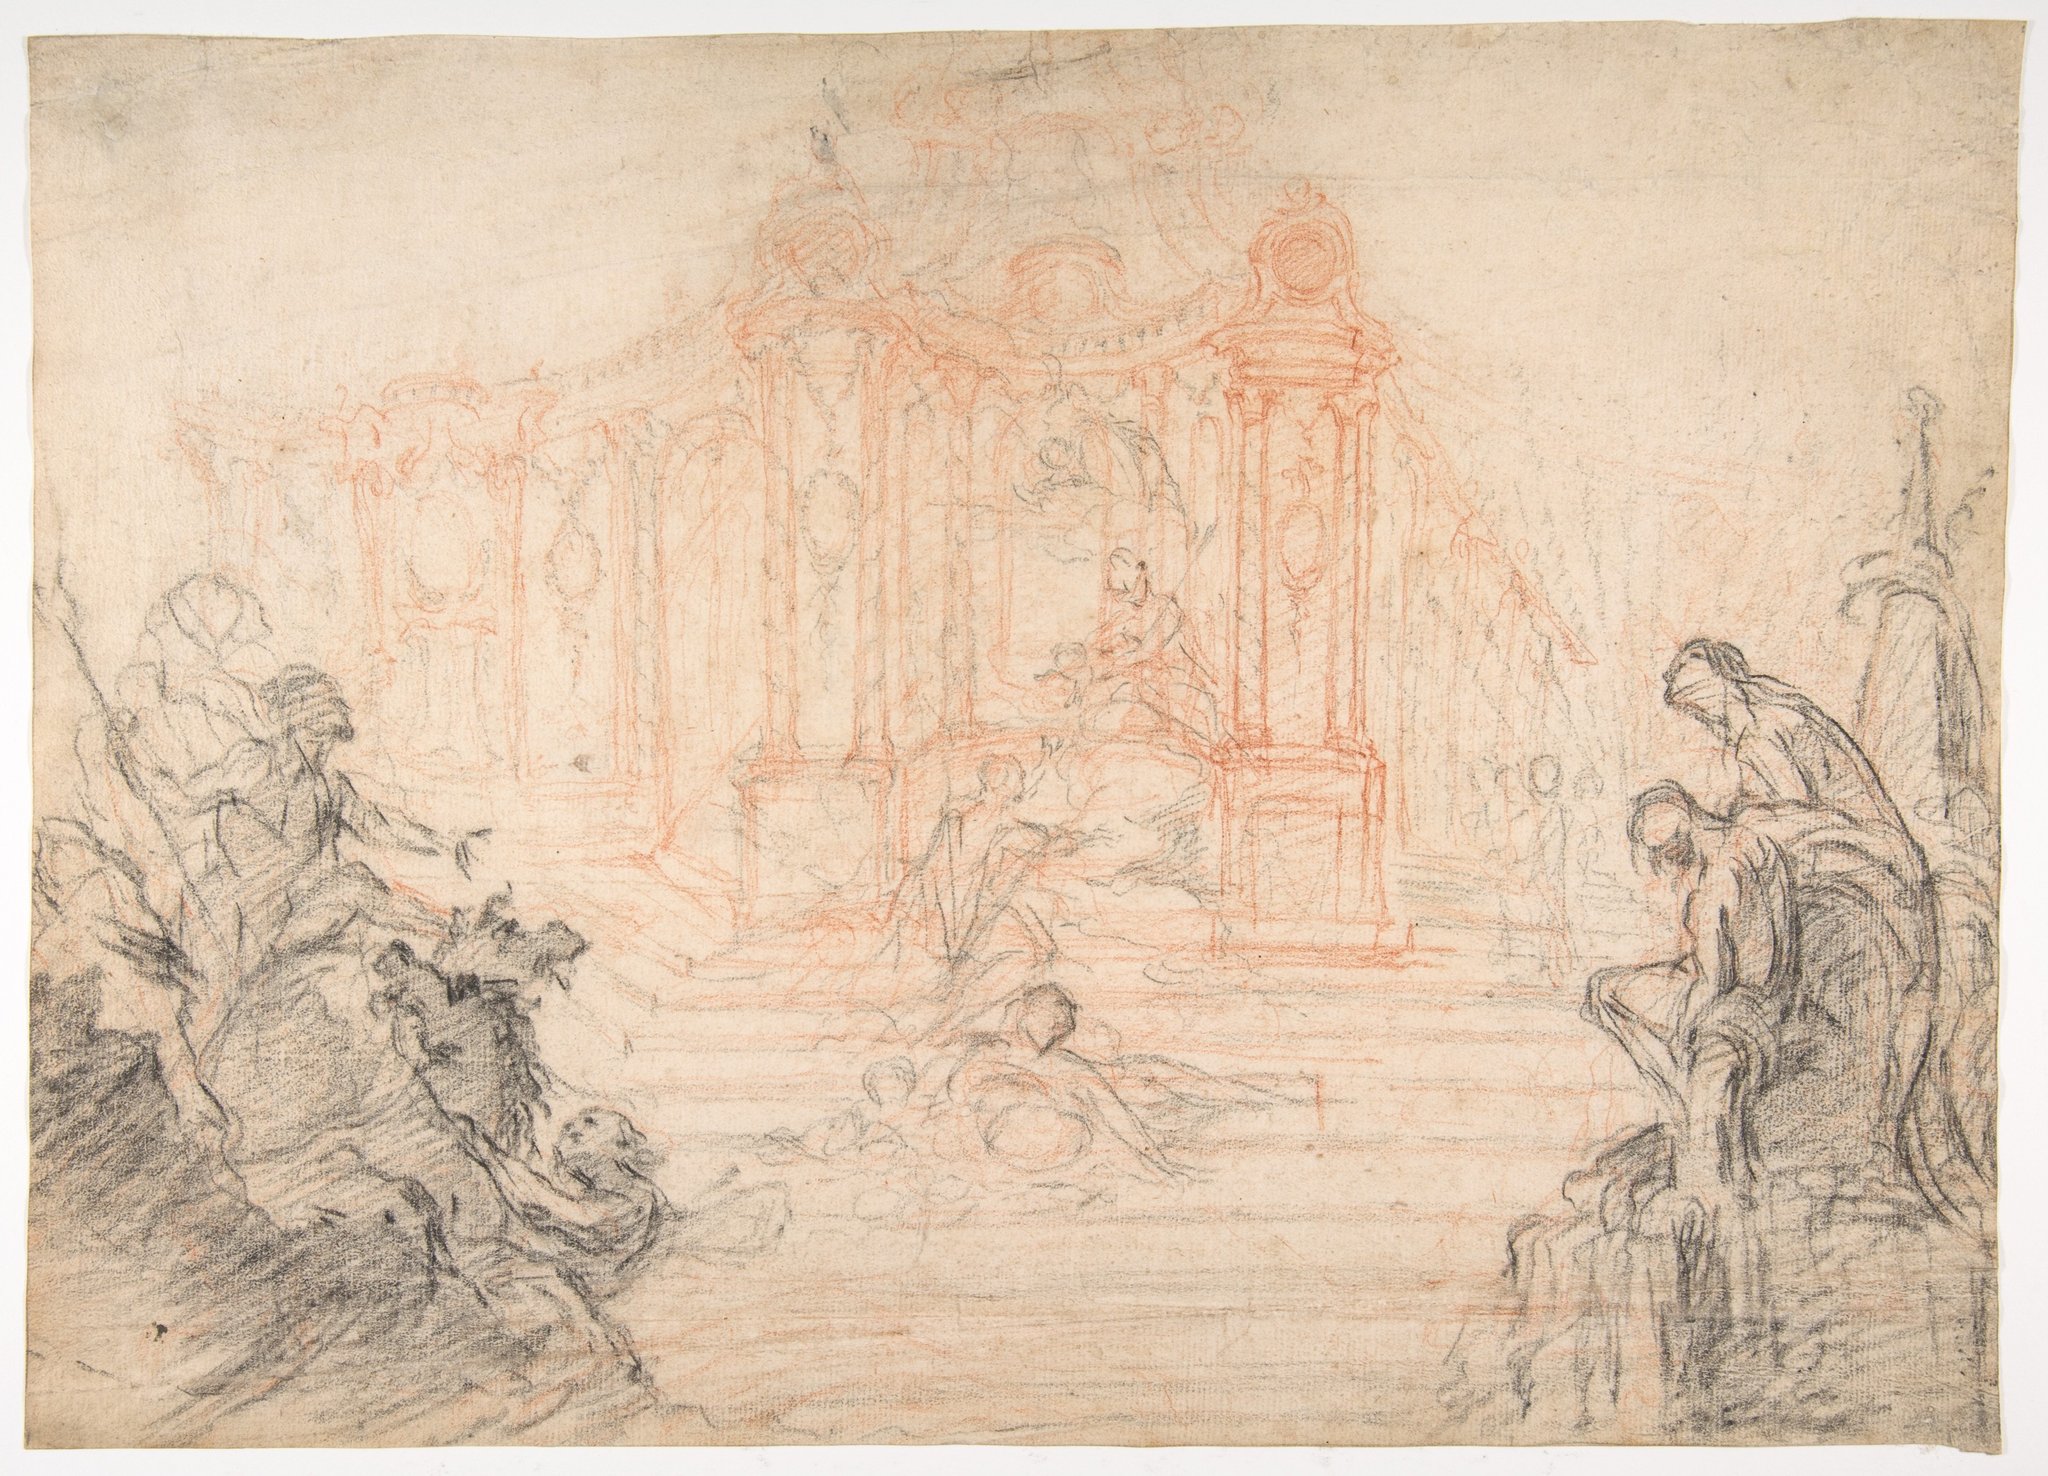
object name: drawing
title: Study for a Festival Machine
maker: laurent hubert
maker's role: artist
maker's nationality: french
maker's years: 1780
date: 1701-1800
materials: chalk, graphite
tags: crowd